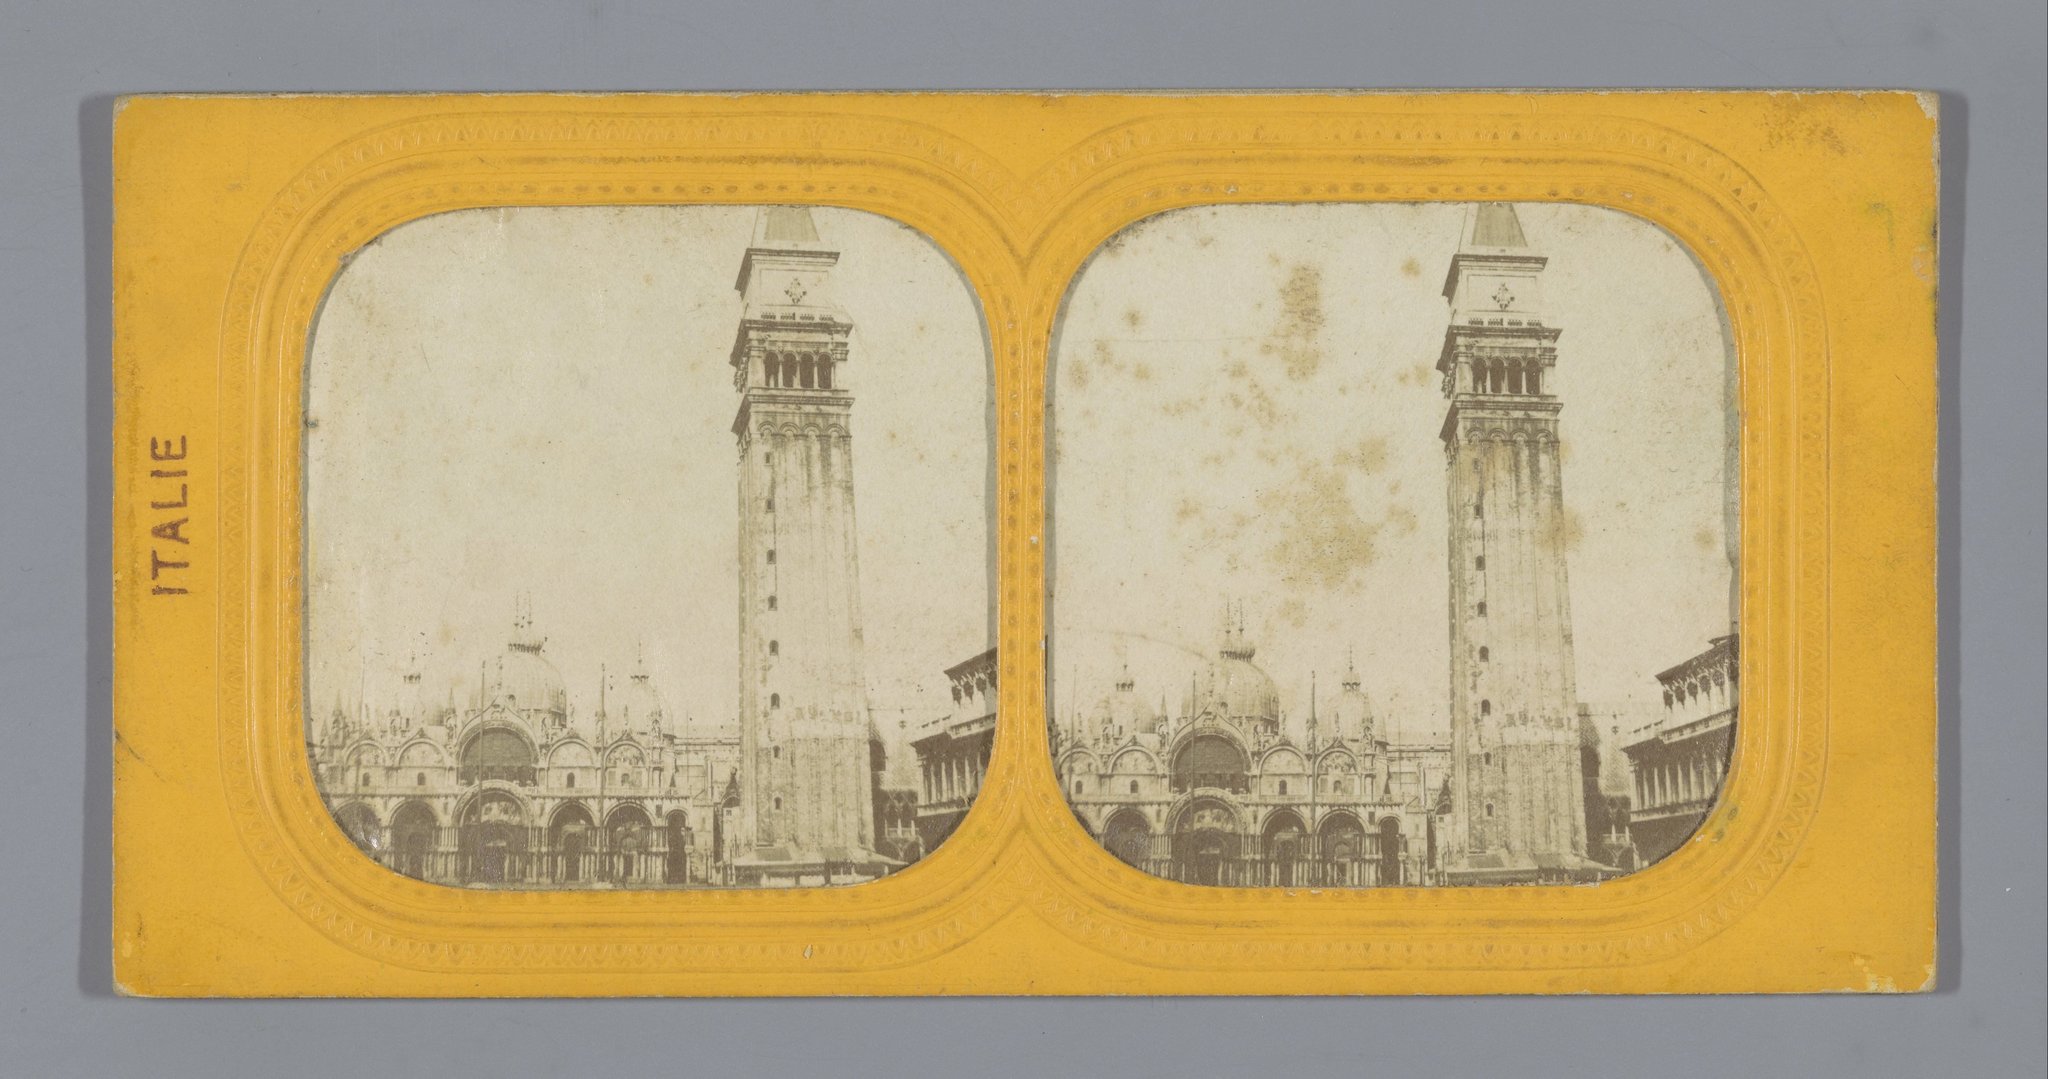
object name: tissue stereograph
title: Italie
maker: Anonymous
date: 1855-1875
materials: cardboard, paper, photographic support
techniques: albumen print, hand coloring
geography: venice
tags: parts of church exterior and annexes: campanile